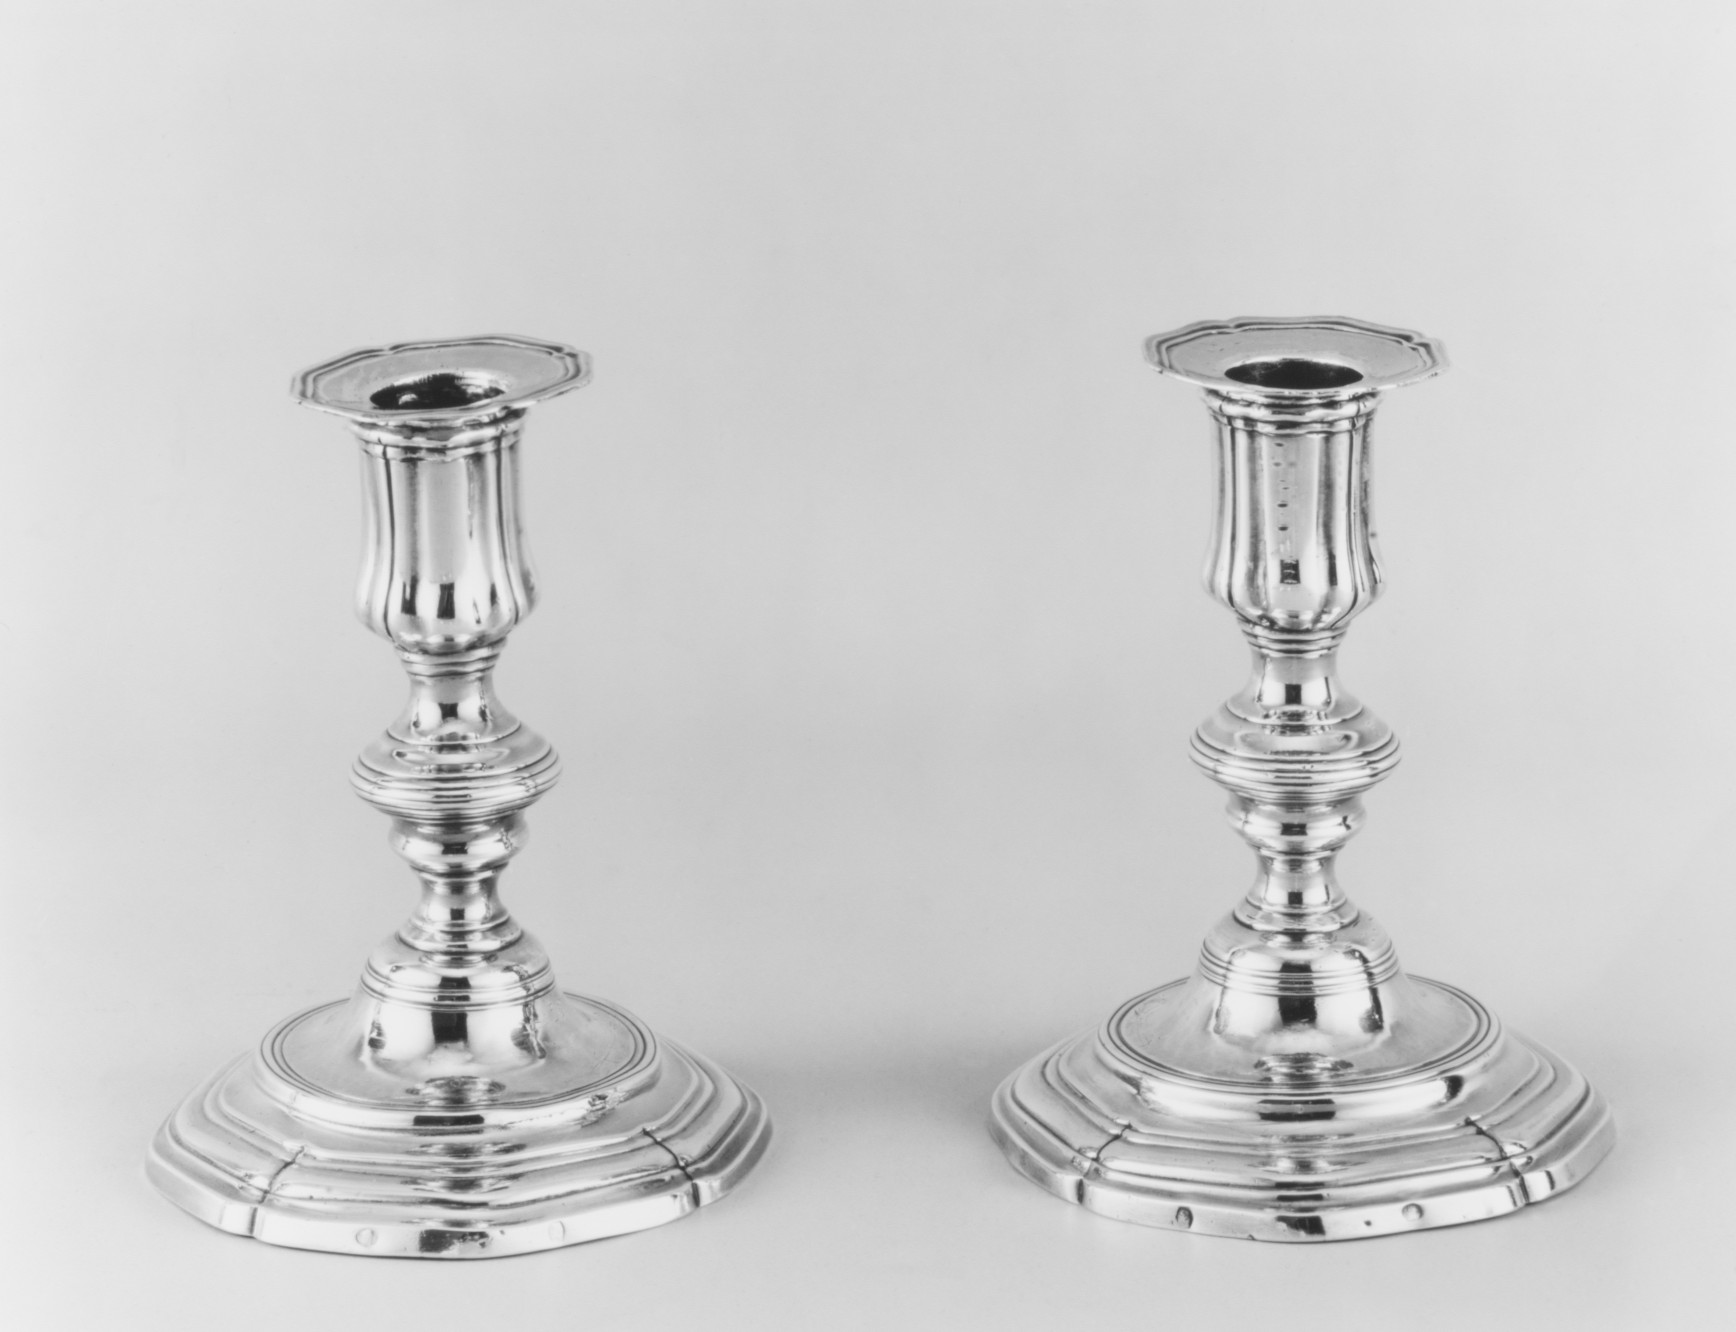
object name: candlestick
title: Pair of candlesticks (part of a toilet service)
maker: antoine plot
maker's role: maker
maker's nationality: french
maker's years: 1701-1772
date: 1765-1766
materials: silver